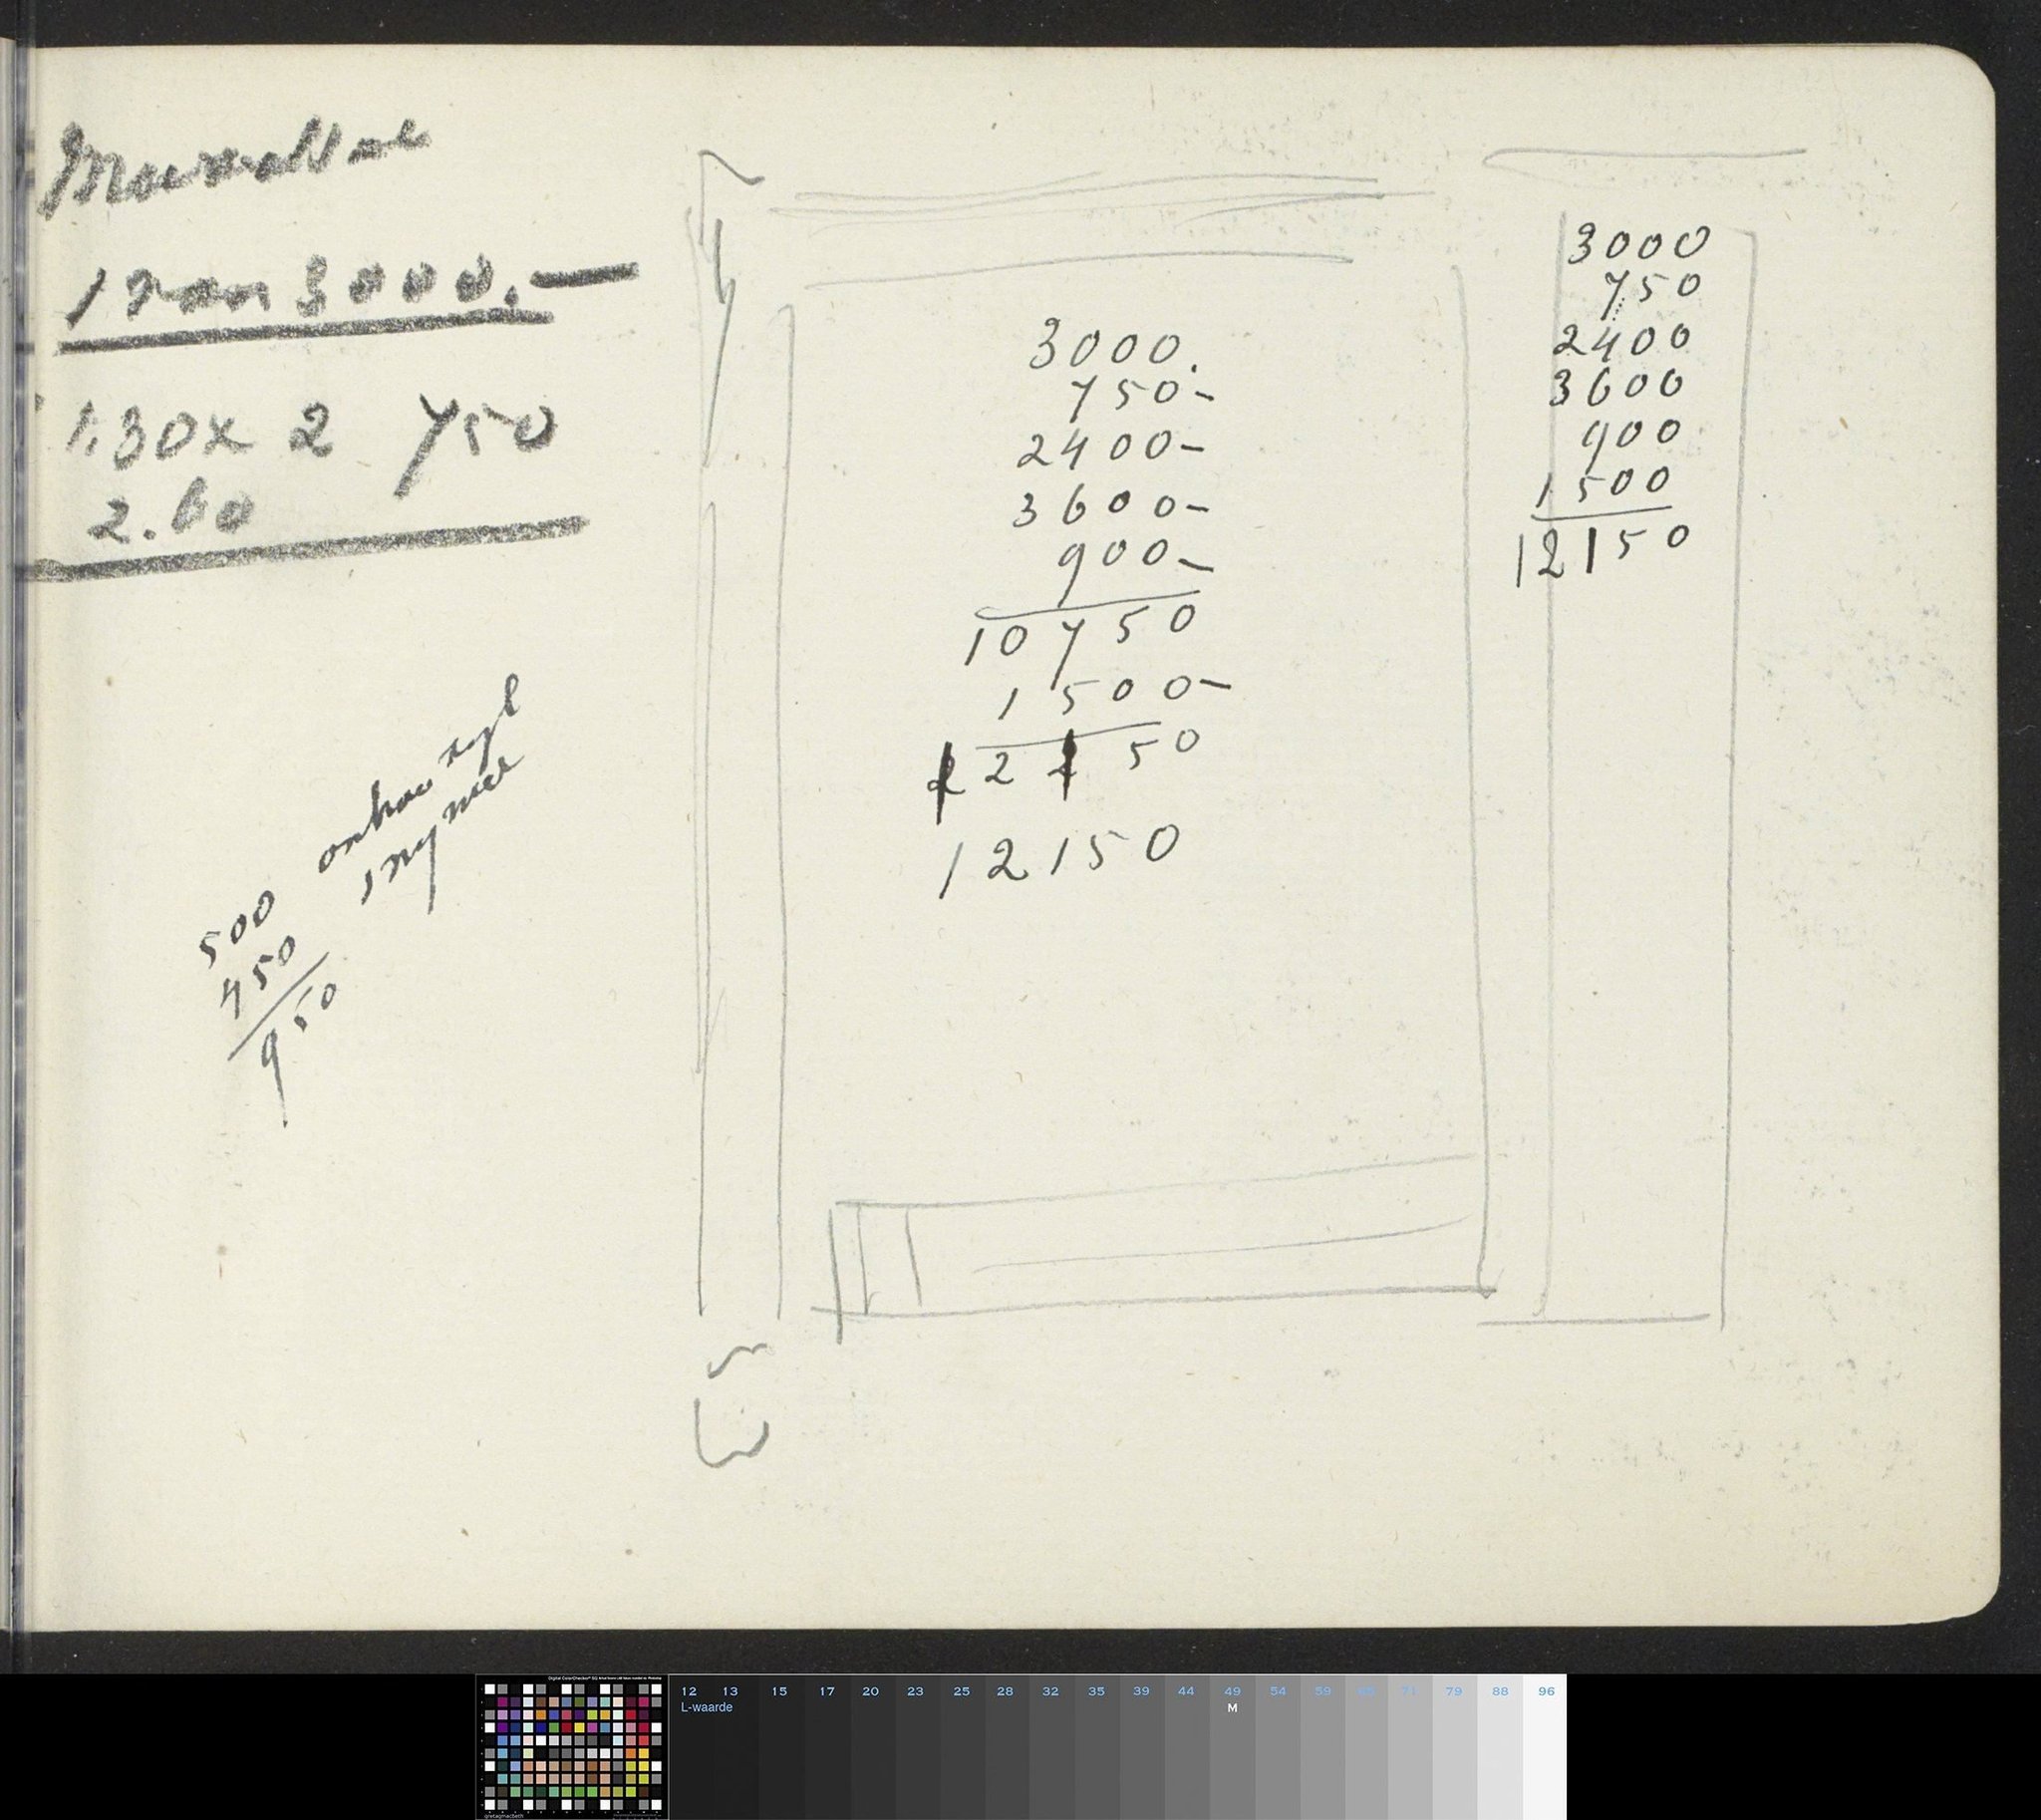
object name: sketchbook leaf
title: Rechthoek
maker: carel adolph lion cachet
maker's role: draughtsman, print maker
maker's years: 1864-1945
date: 1928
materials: paper, pencil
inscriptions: annotation: ‘[...]’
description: Mogelijk een ontwerp voor een wand. Blad 23 recto uit een schetsboek met 24 bladen.